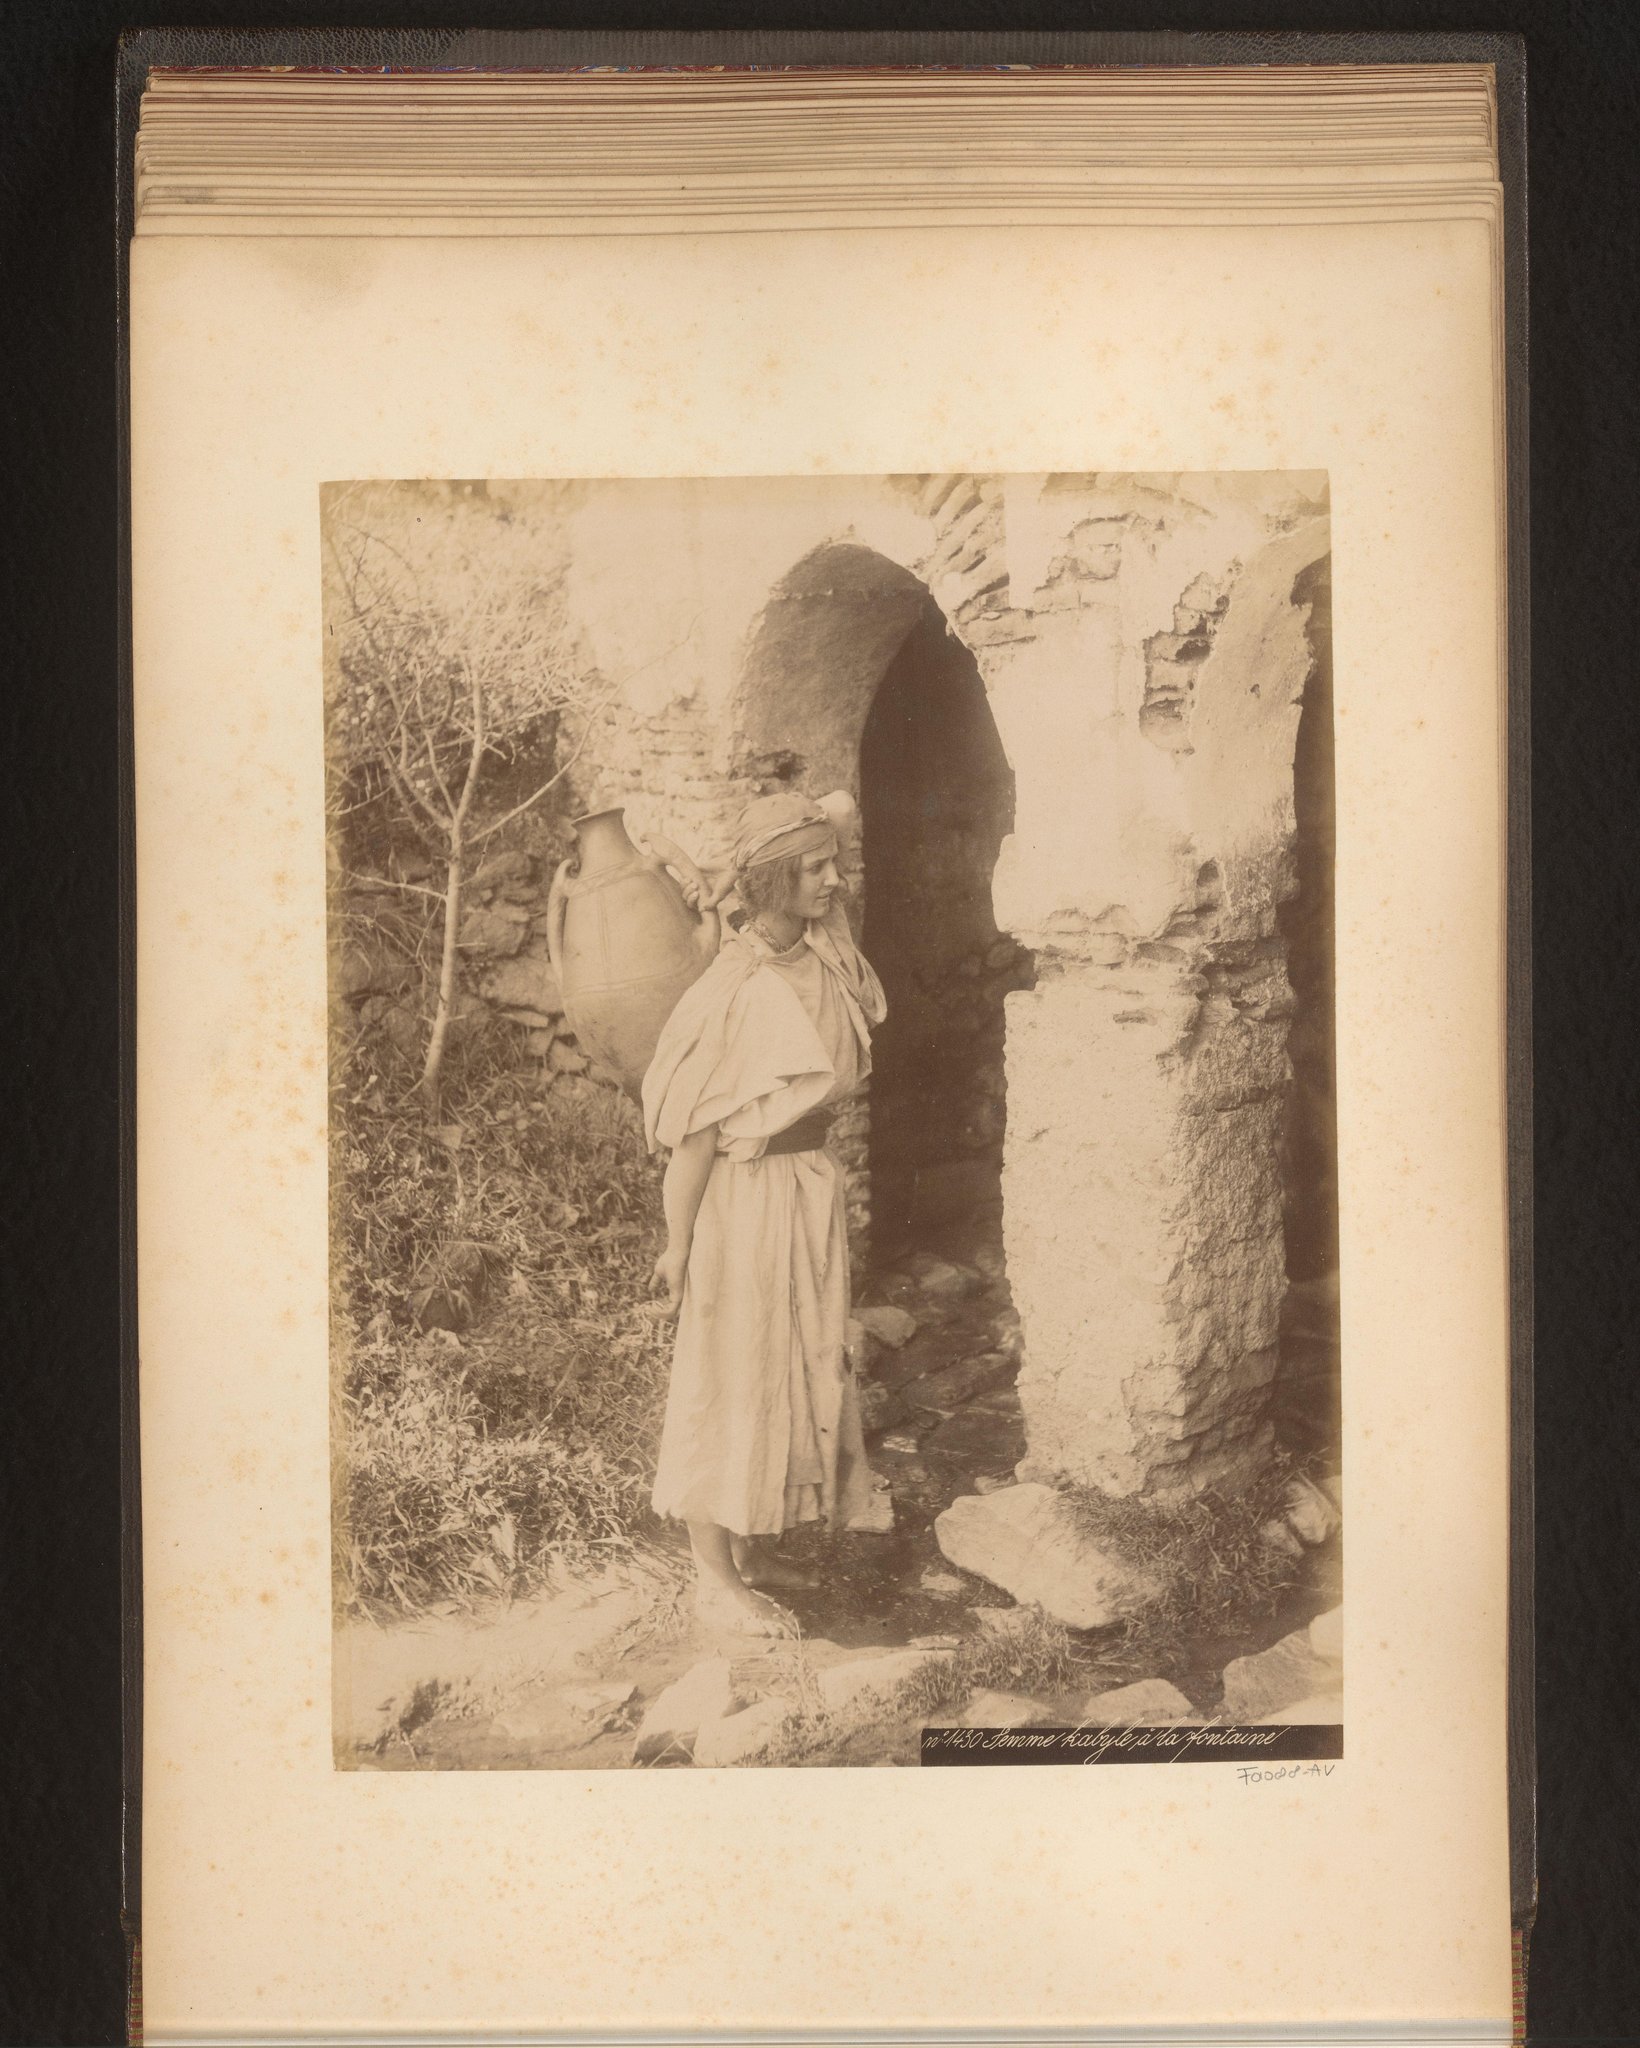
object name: album leaf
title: Vrouw met waterkruik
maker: Anonymous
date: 1880-1900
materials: photographic support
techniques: albumen print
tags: adult woman, container of ceramics: jar, jug, pot, vase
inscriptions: number: ‘1430’